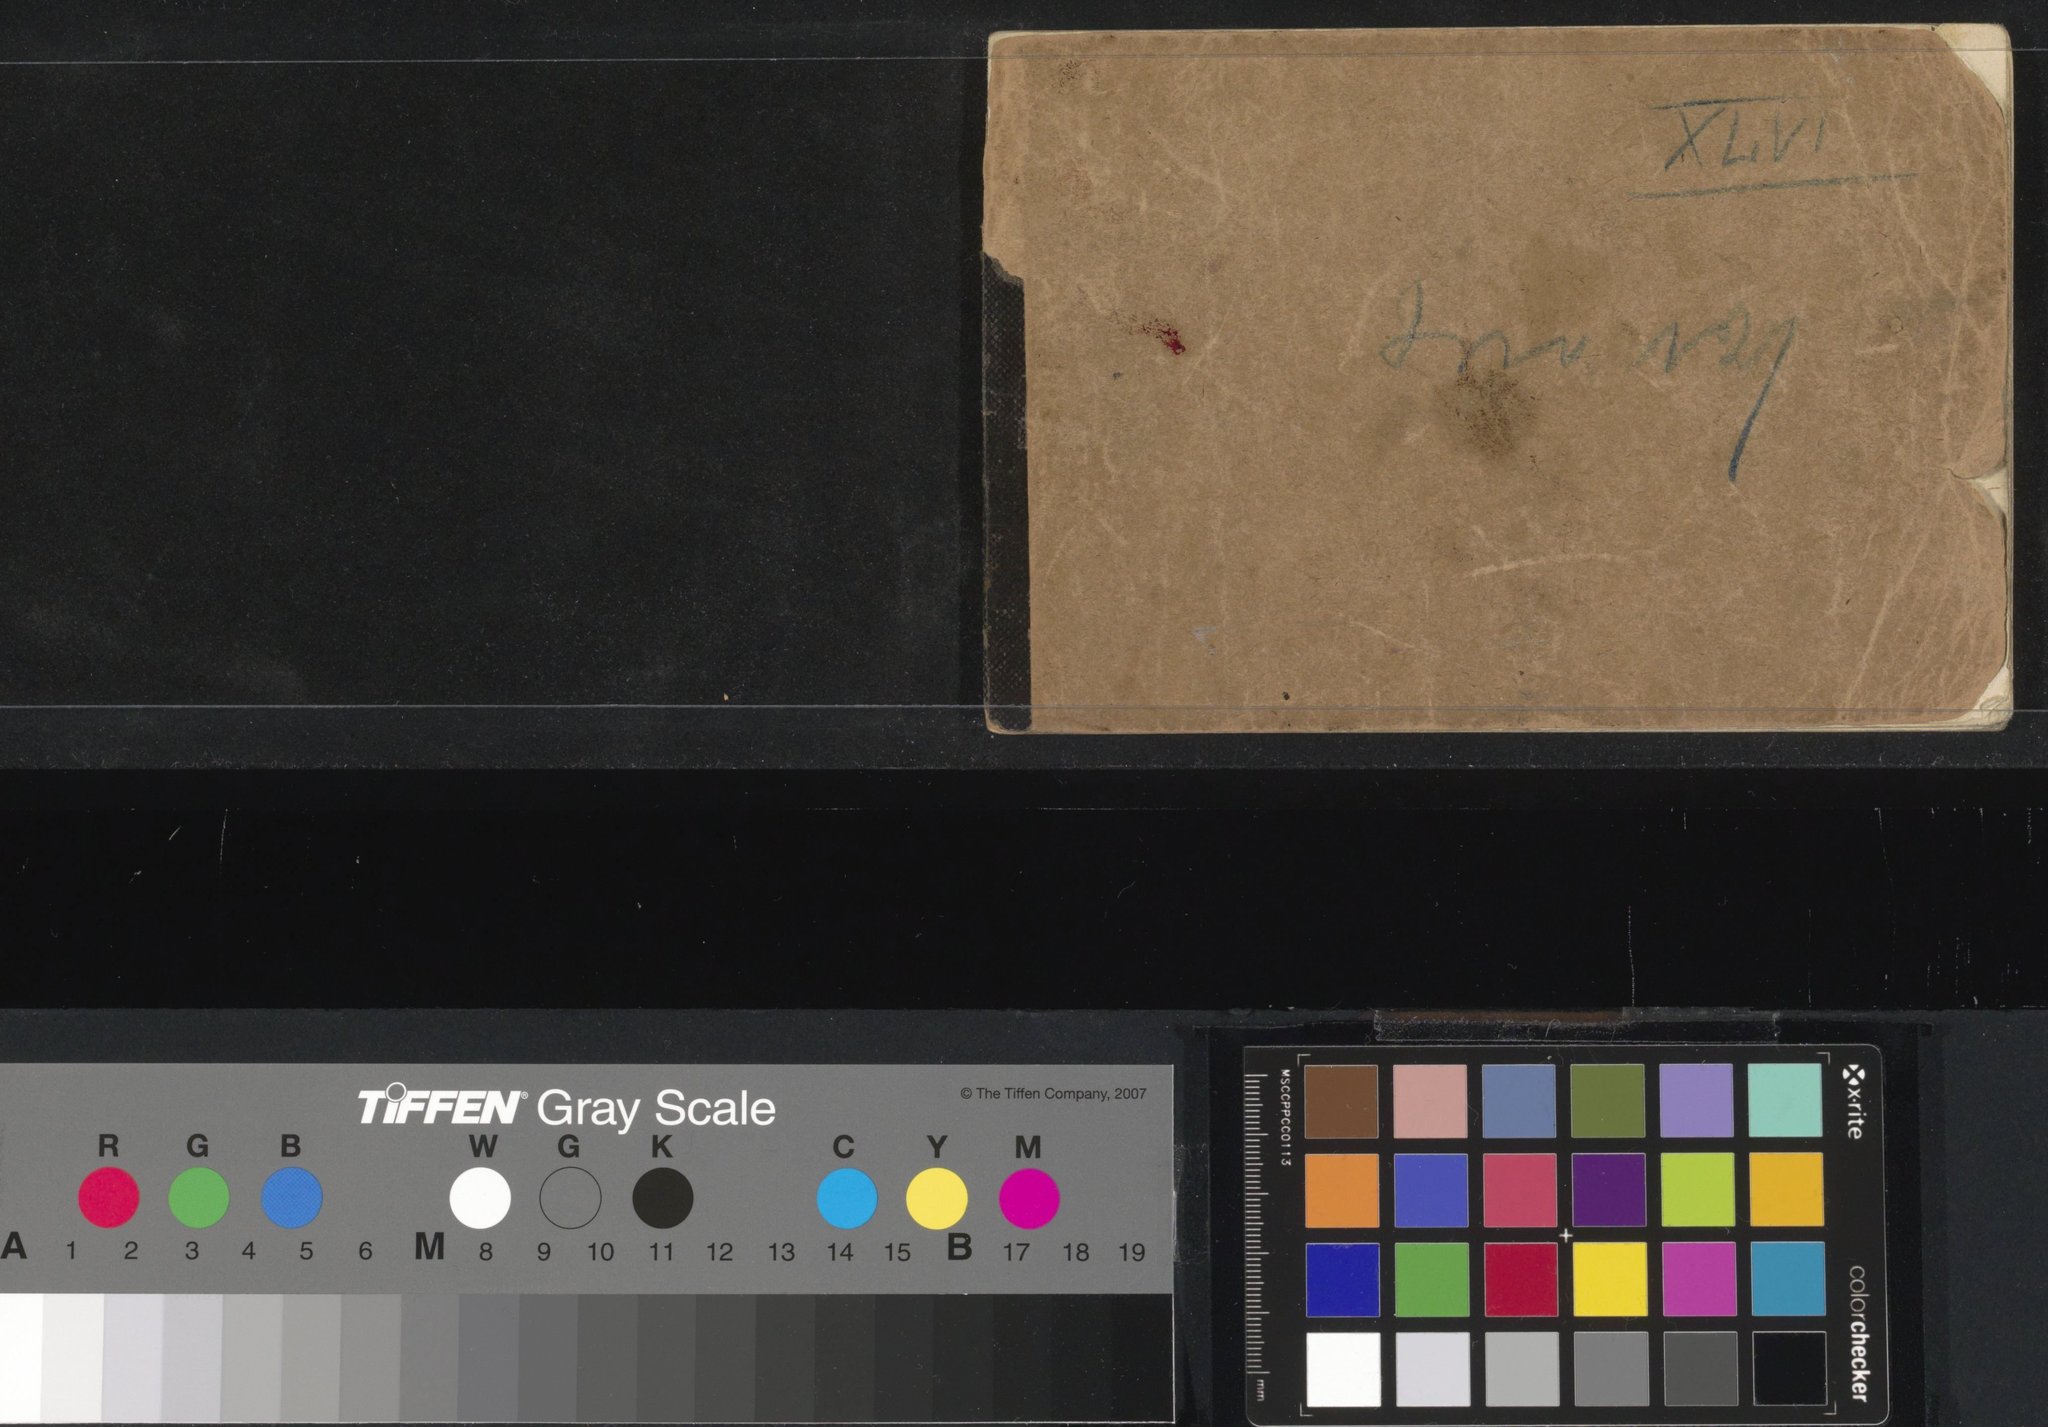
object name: sketchbook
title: Schetsboek XLVI met 32 pagina's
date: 1875-1934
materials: chalk, linen, paper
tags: the (nude) human figure; 'corpo humano' (ripa), street (+ city(-scape) with figures, staffage), london, paris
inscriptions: retailer's mark: ‘[...] / Léon Besnard / 60, Rue de la Rochefoucauld / [...] / Lefranc & Cie’, collector's mark: Lugt 2228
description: Schetsboek nr. XLVI bestaande uit 32 pagina's met figuurstudies en straatgezichten, mogelijk te Londen of Parijs.